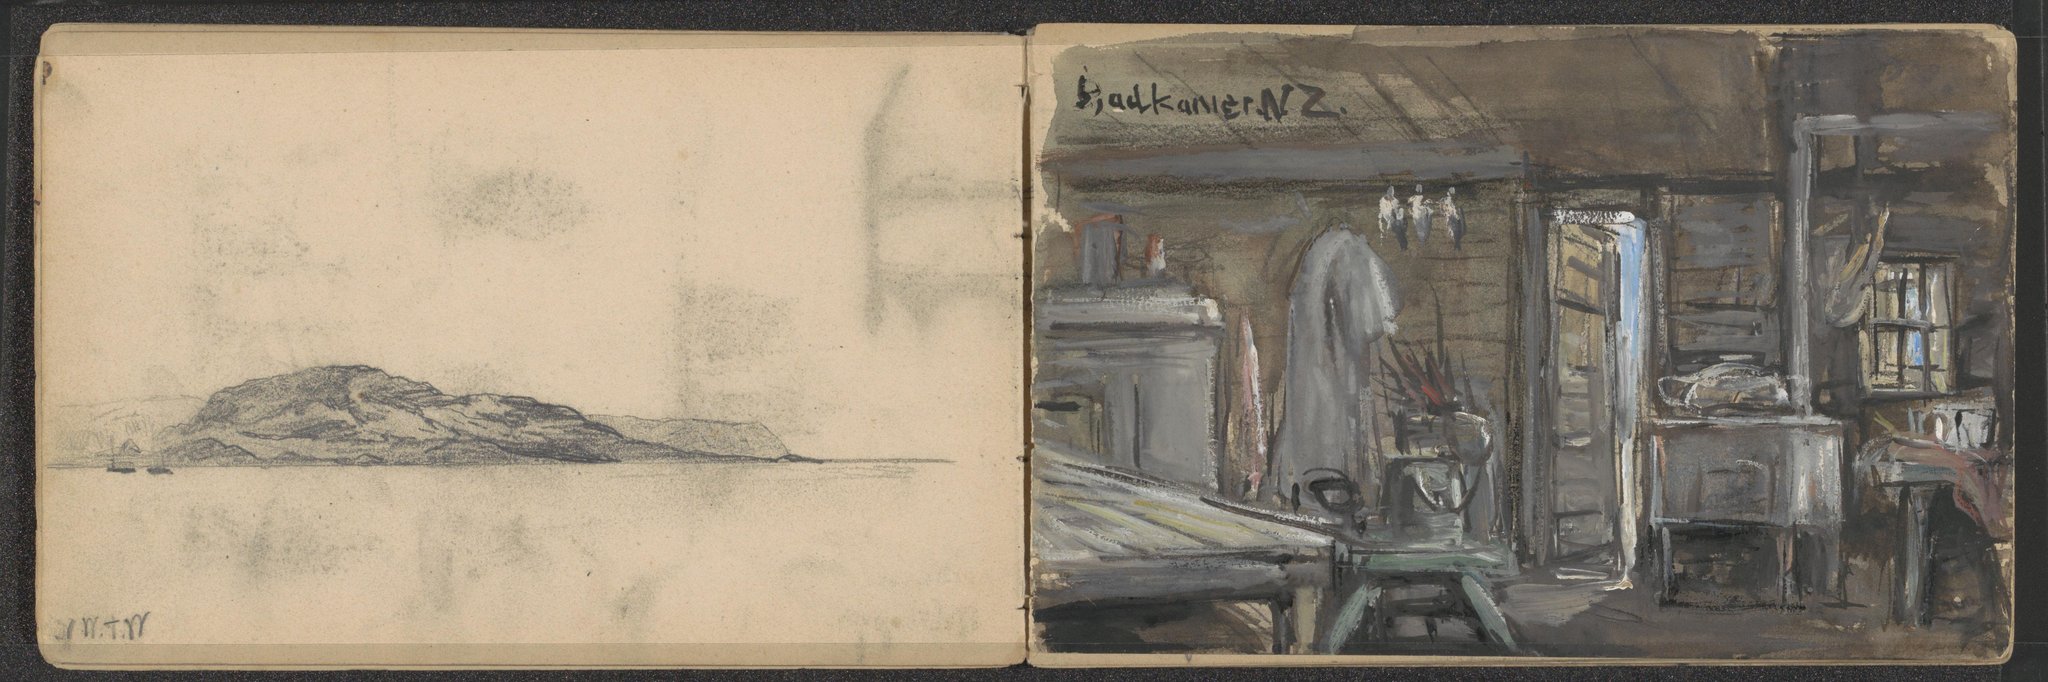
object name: sketchbook leaf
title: Gezicht op Nova Zembla, zijde noord-west ten westen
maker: louis apol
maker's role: draughtsman, painter, print maker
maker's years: 1850-1936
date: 1880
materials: paper, pencil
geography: novaya zemlya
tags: coast (in polar regions)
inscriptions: annotation: ‘N.W.T.W’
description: Blad 11 verso uit een schetsboek met 35 bladen betekend tijdens de expeditie naar Nova Zembla in 1880.